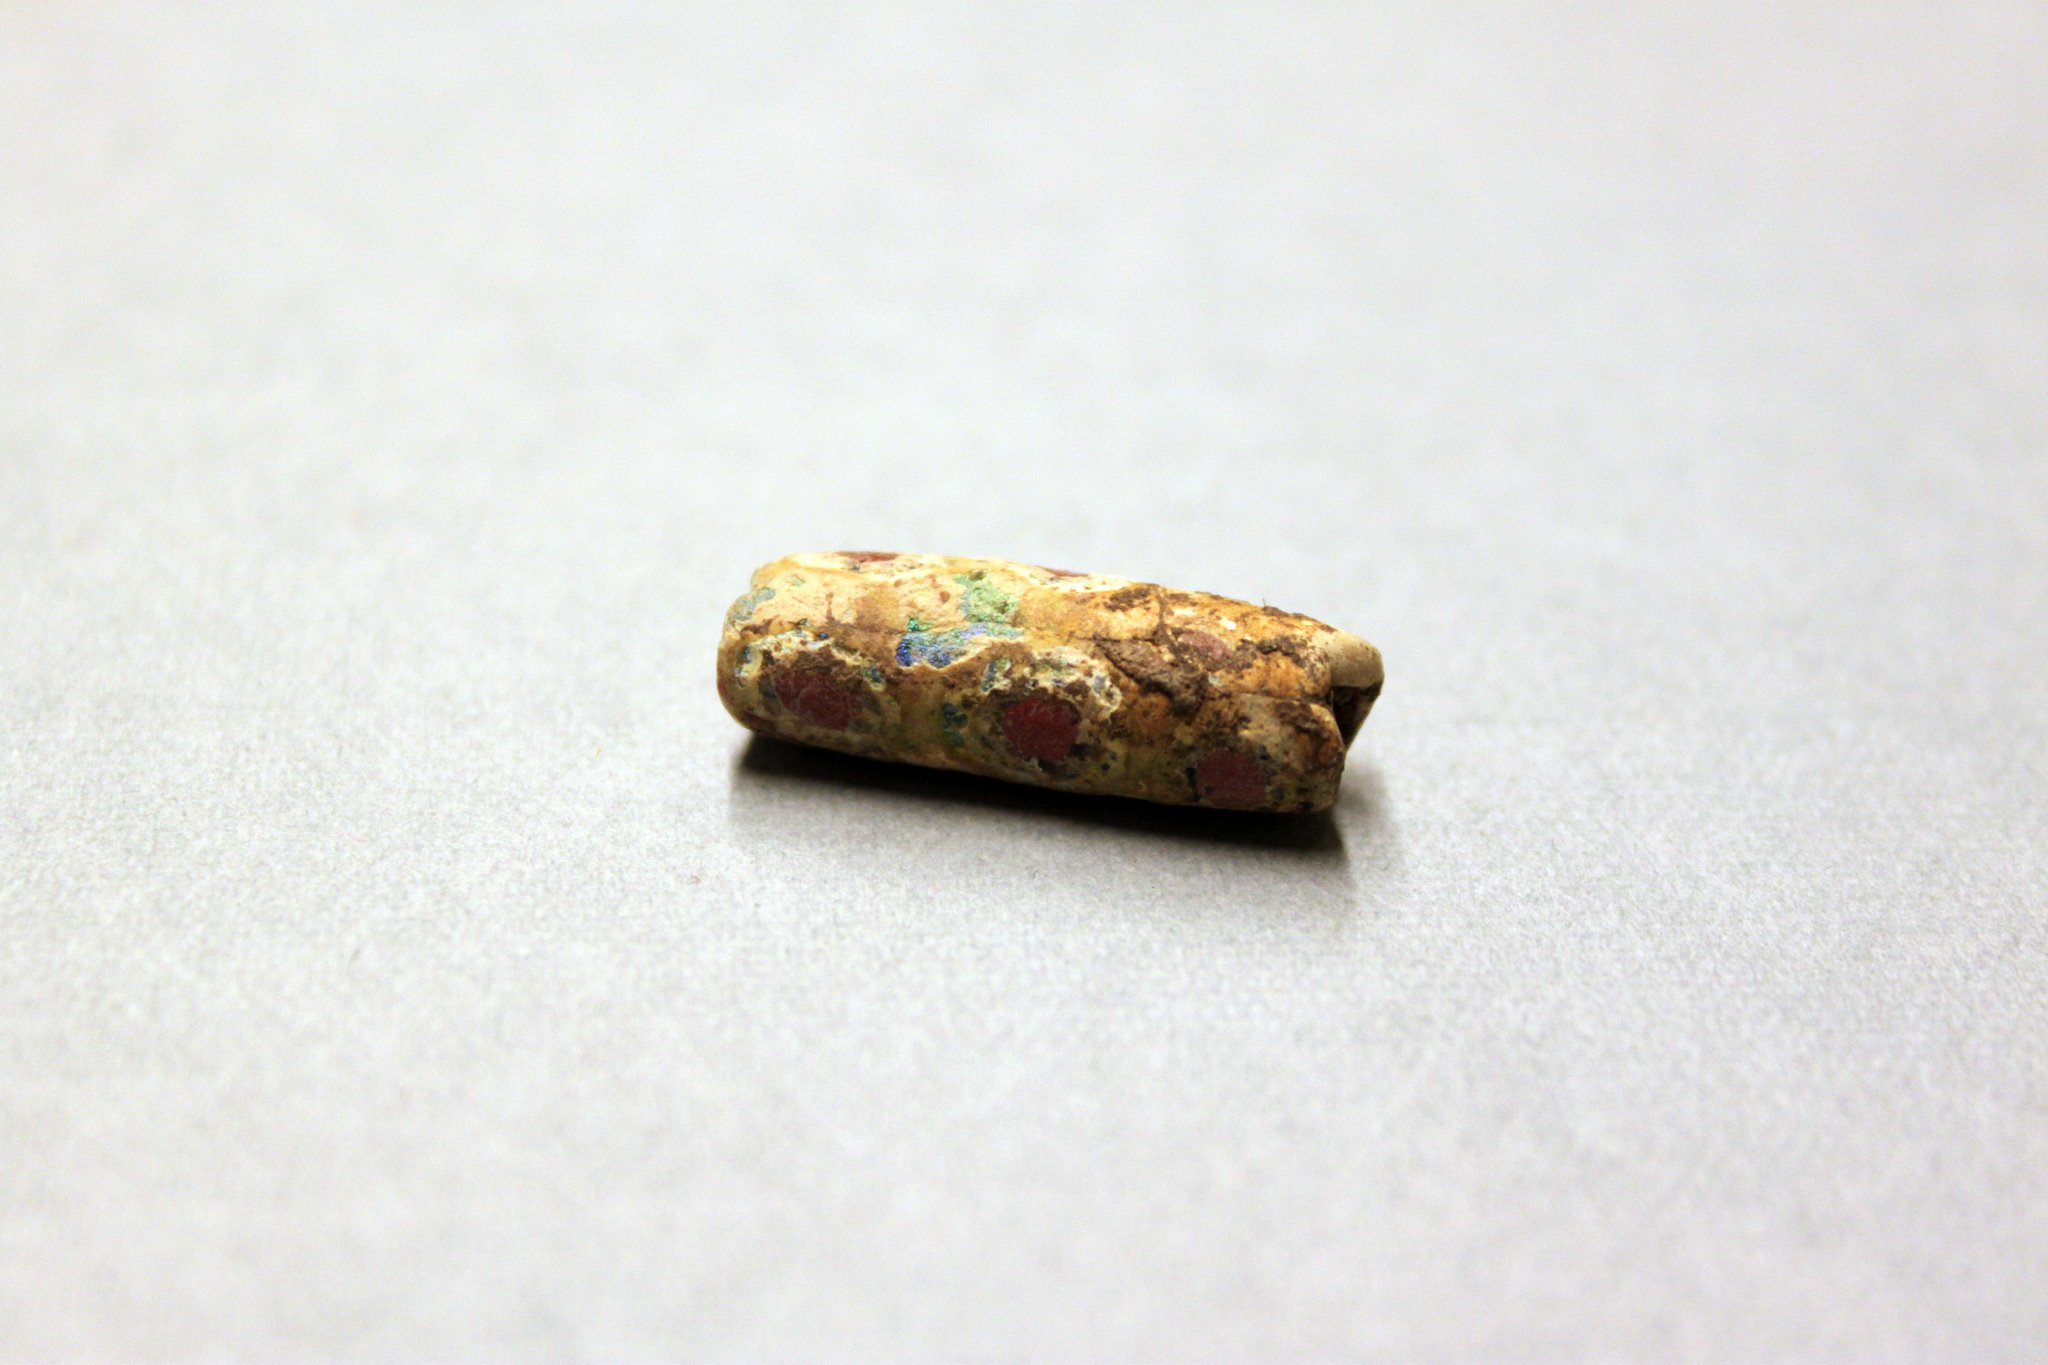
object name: bead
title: Beads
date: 701-1300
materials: glass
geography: iran